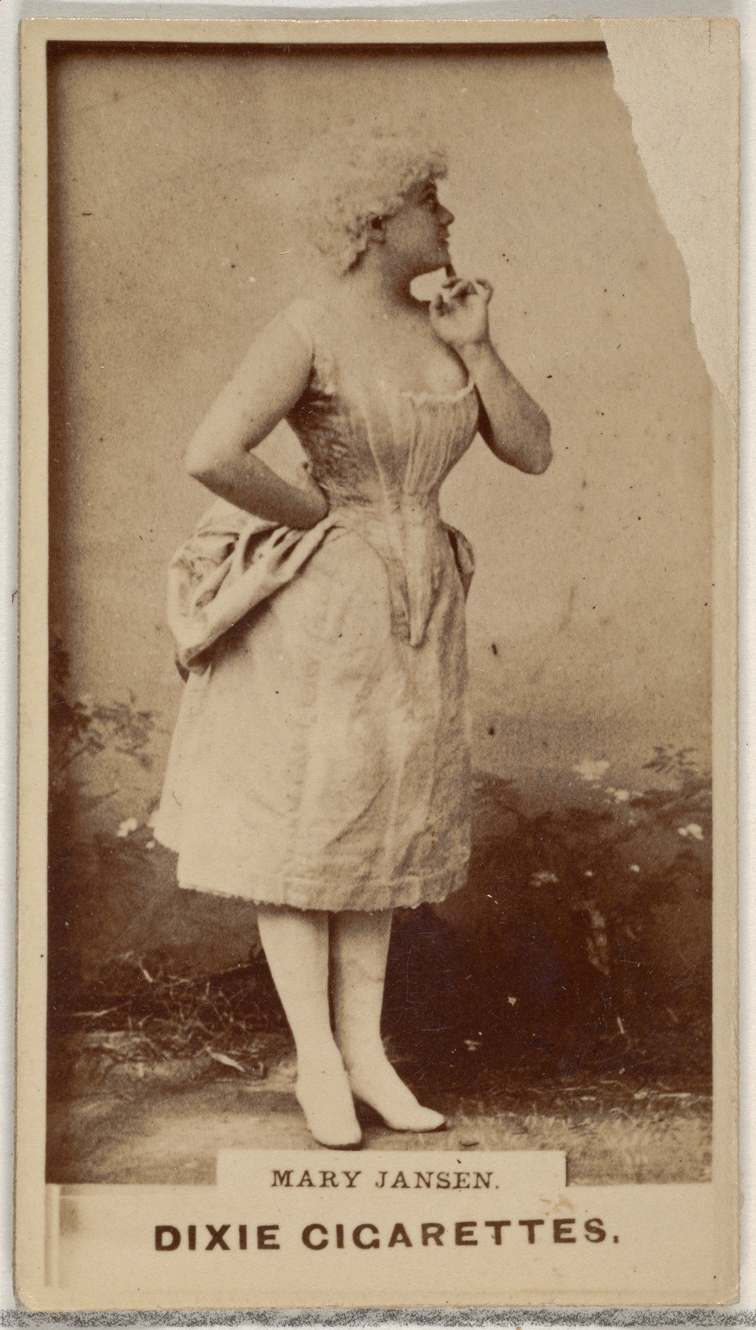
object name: photograph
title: Mary Jansen, from the Actors and Actresses series (N45, Type 7) for Dixie Cigarettes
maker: allen & ginter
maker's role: publisher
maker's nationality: american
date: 1888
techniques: albumen silver print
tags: portraits,profiles,women,actresses